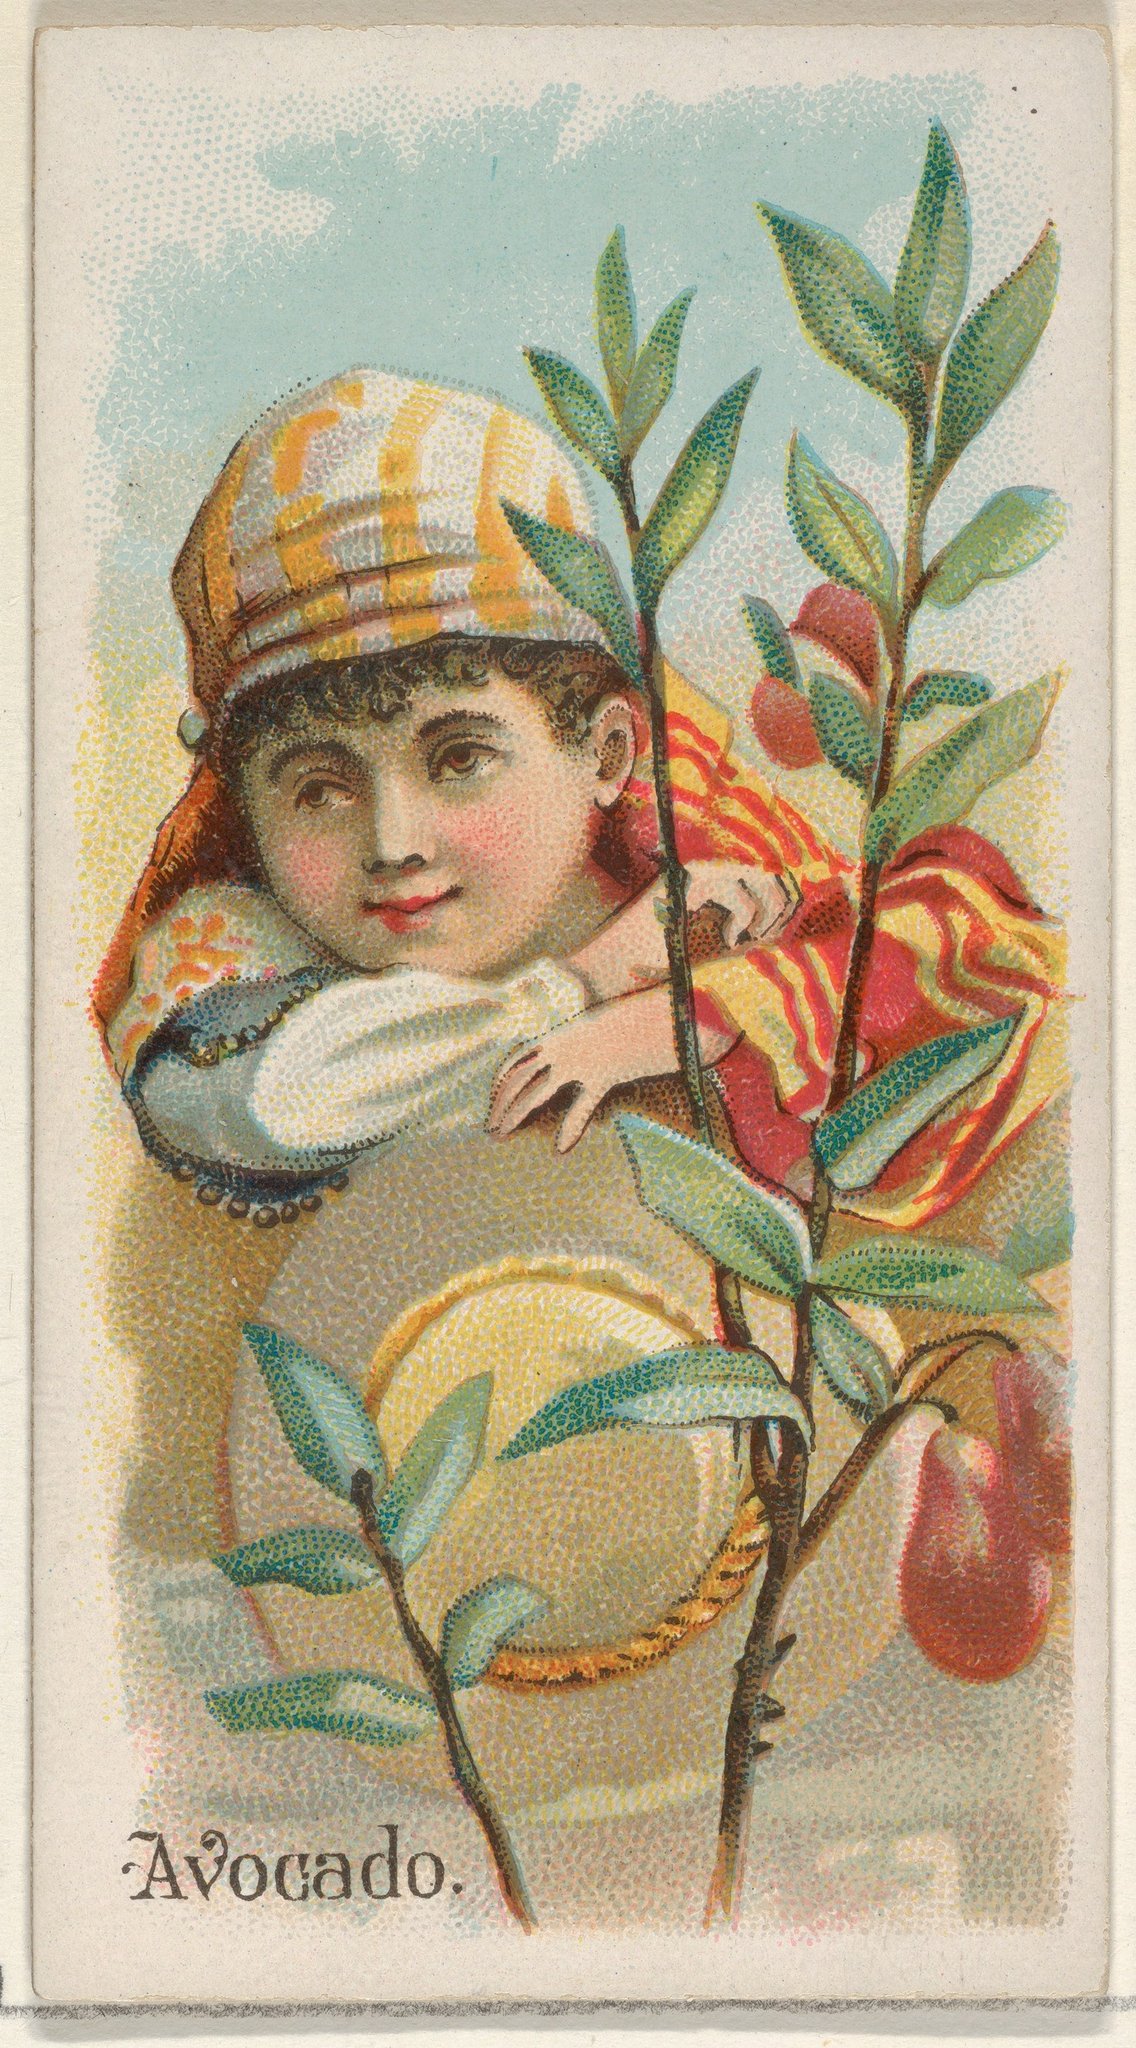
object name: print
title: Avocado, from the Fruits series (N12) for Allen & Ginter Cigarettes Brands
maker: allen & ginter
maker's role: publisher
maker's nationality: american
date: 1891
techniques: color lithograph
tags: fruit,boys